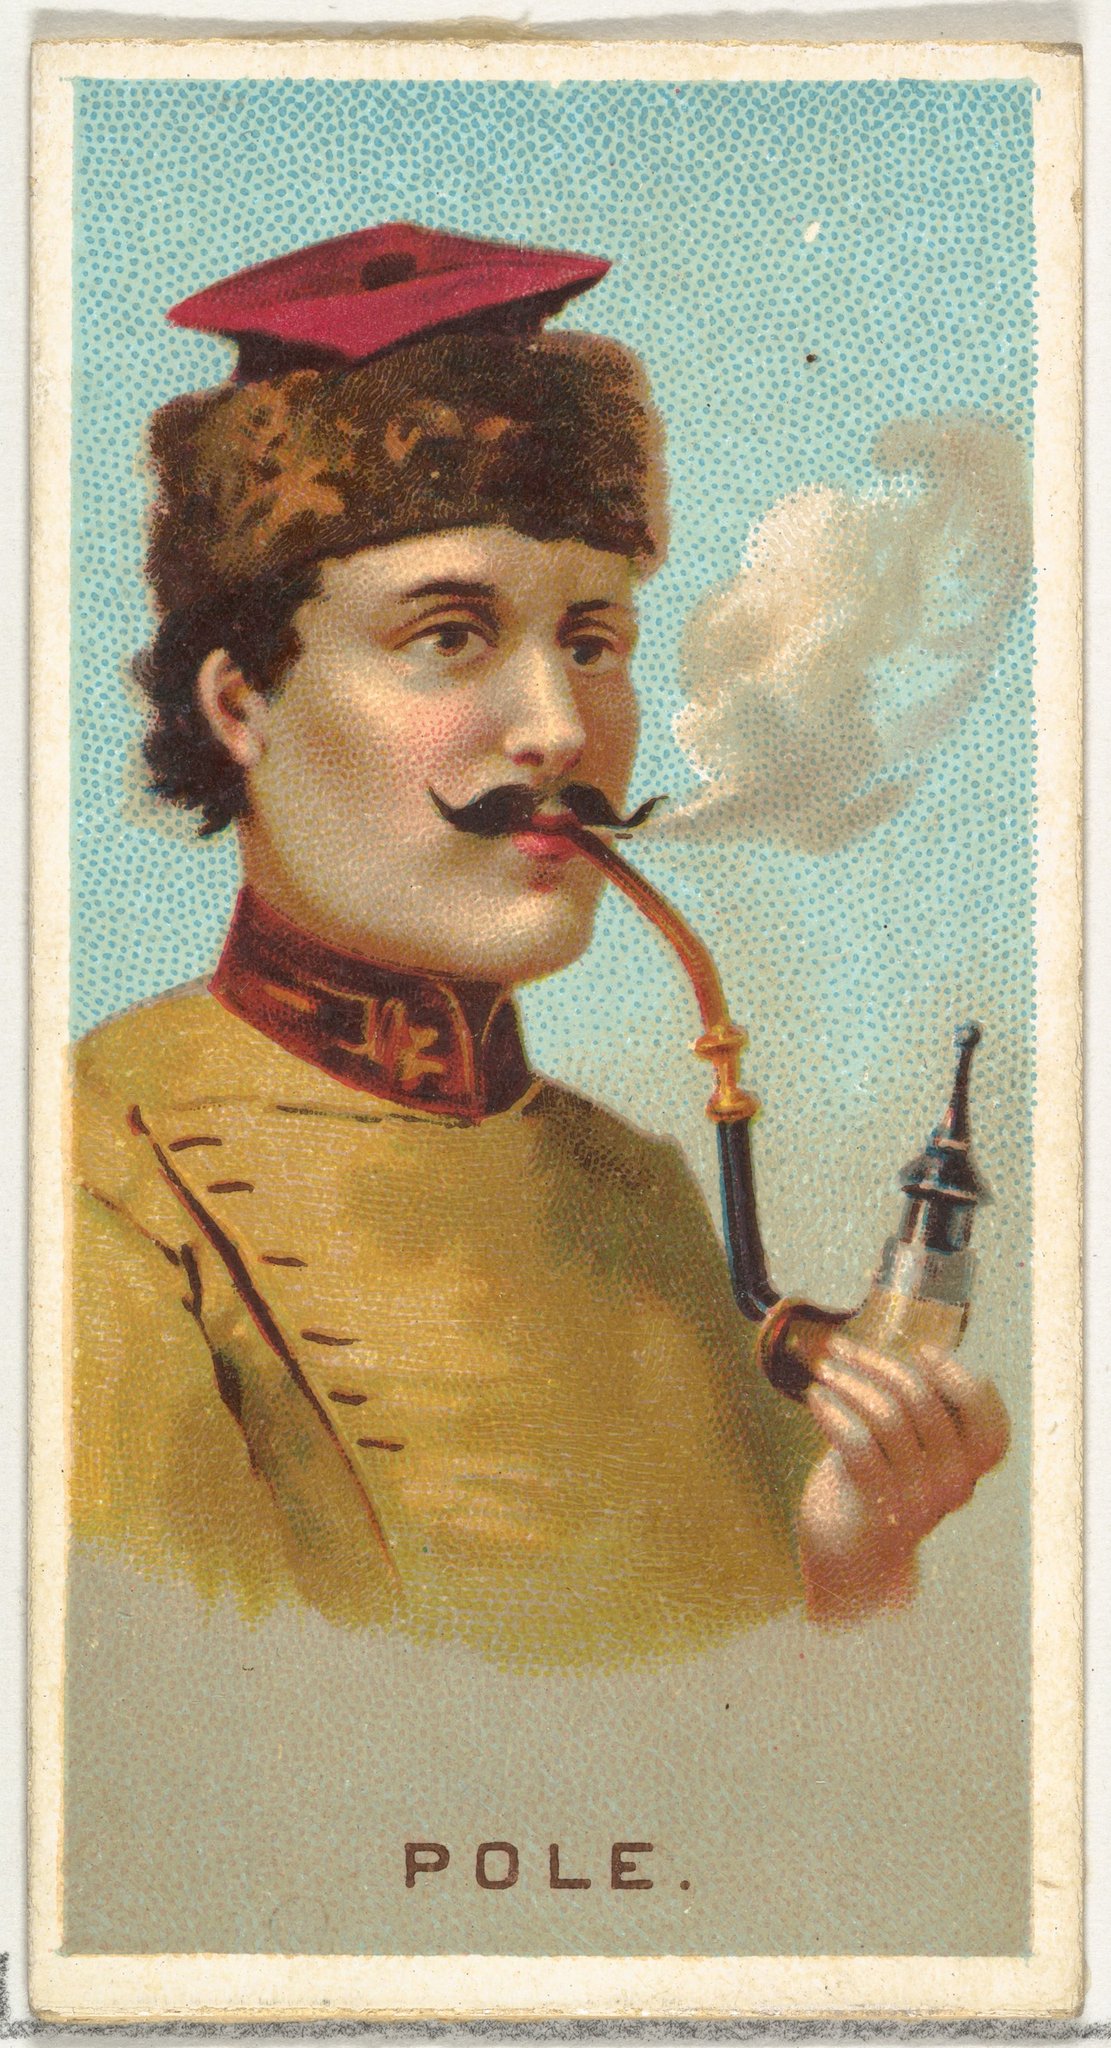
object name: print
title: Pole, from World's Smokers series (N33) for Allen & Ginter Cigarettes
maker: allen & ginter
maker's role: publisher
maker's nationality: american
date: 1888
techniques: color lithograph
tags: men,smoking